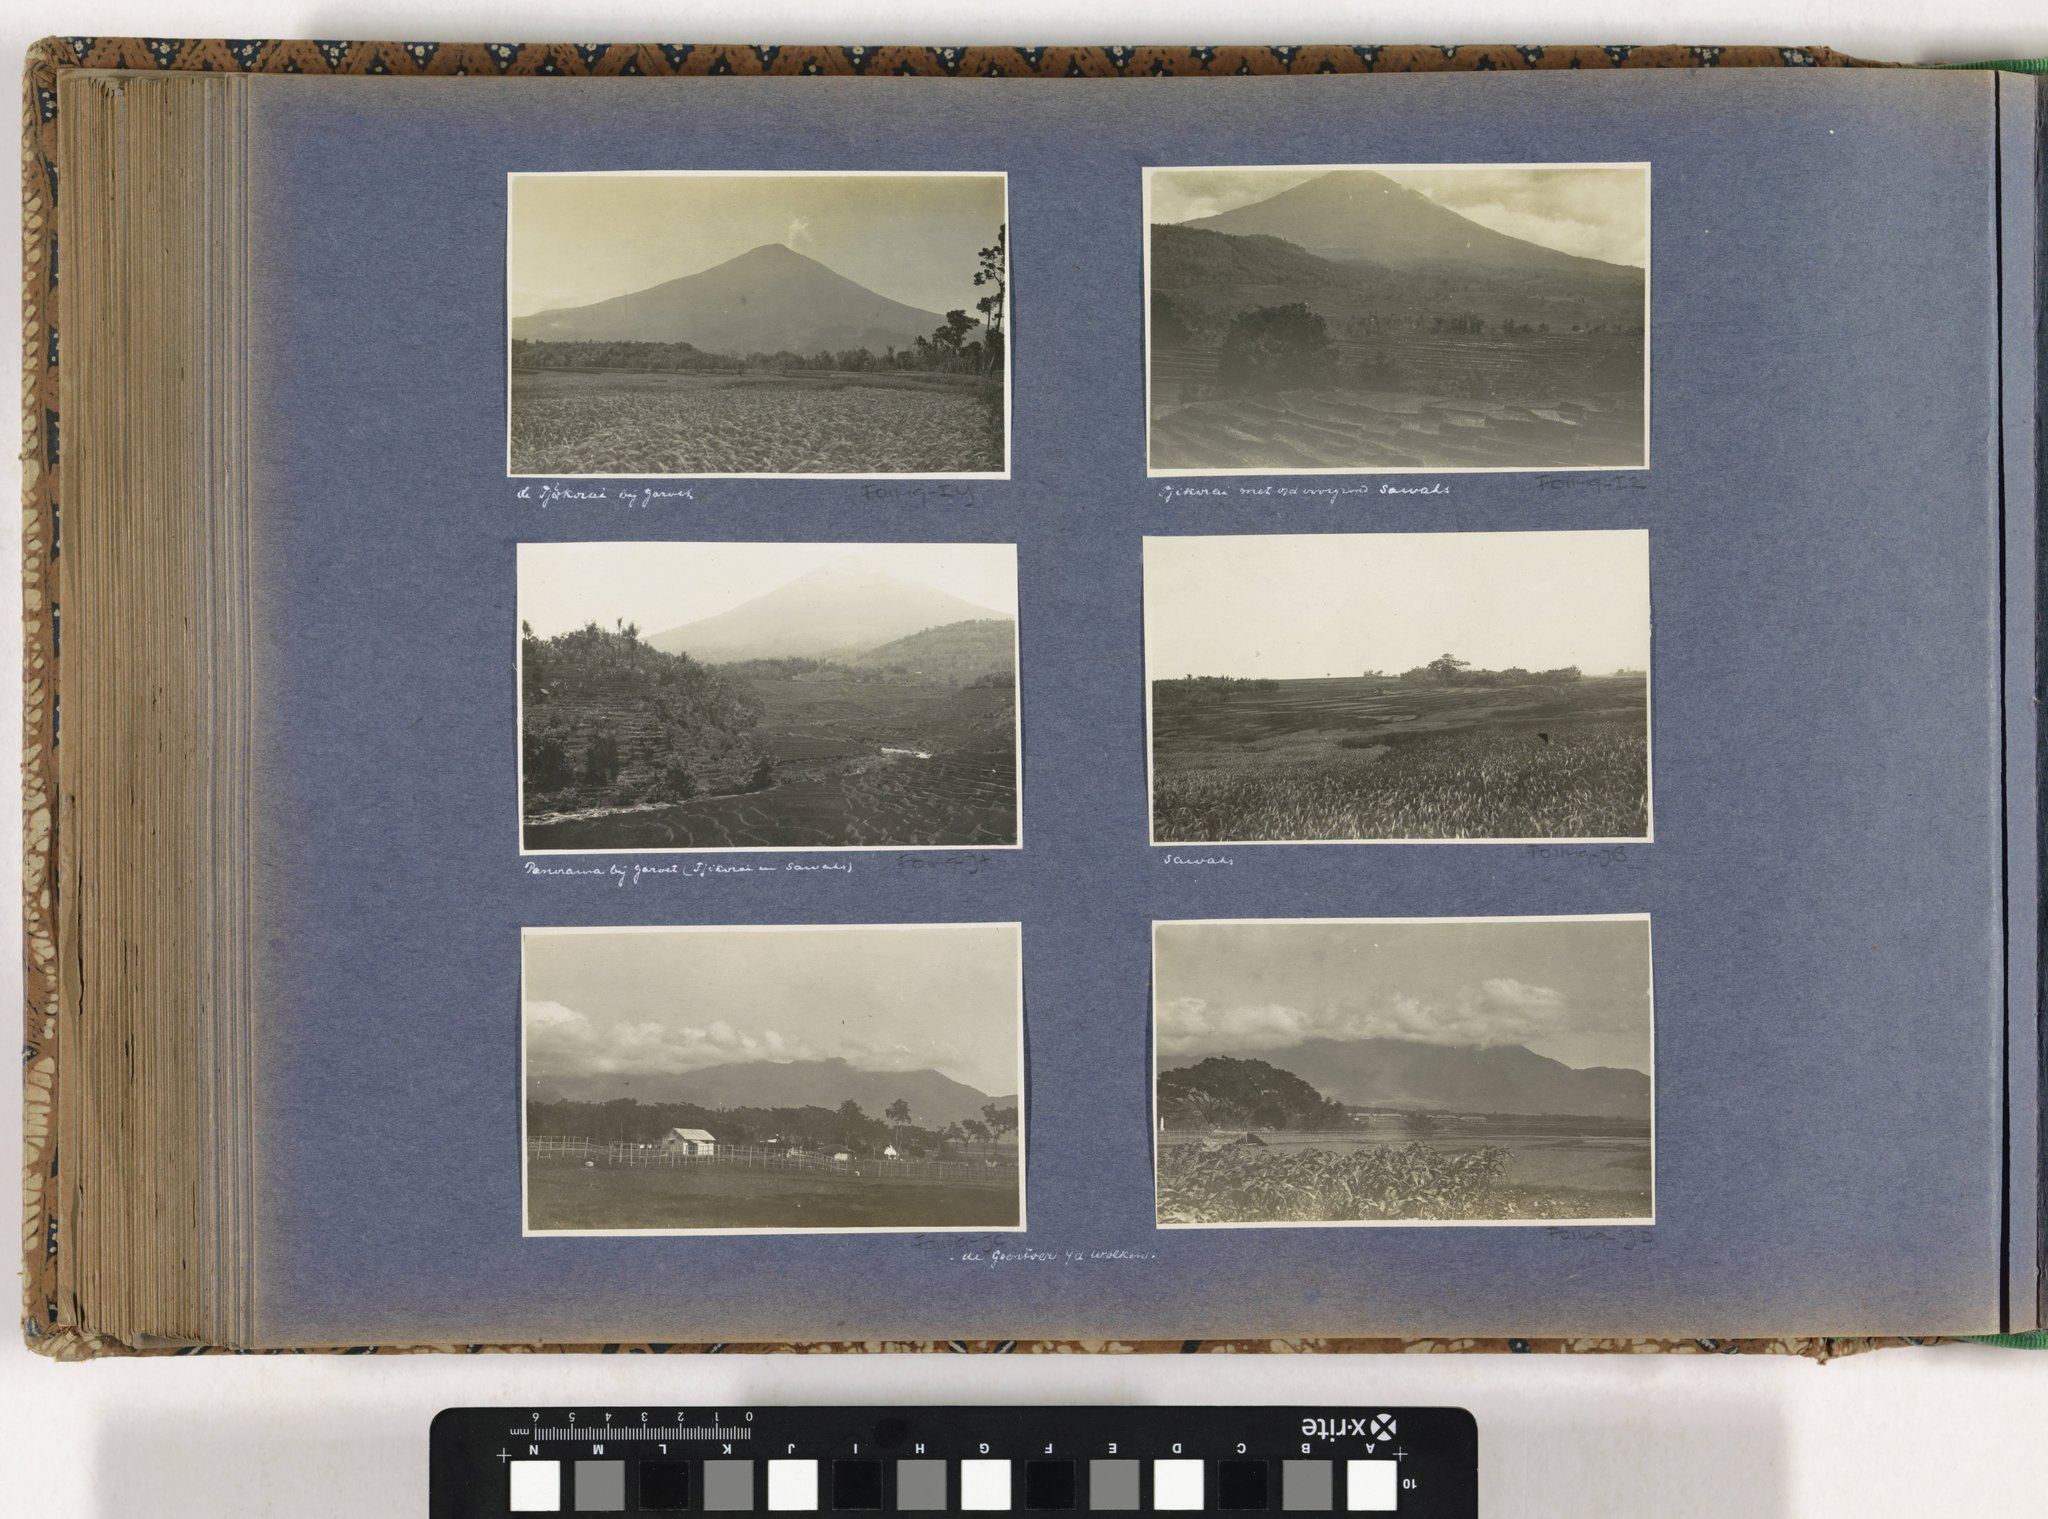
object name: photograph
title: Vulkaan in de wolken: de Goentoer bij Garut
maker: Anonymous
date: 1900-1920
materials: paper, photographic support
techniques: gelatin silver print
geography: garut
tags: clouds, volcano, java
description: Onderdeel van reisalbum met foto's van bedrijvigheid en bezienswaardigheden op Sumatra en Java en van de reis naar en van Nederlands-Indië.